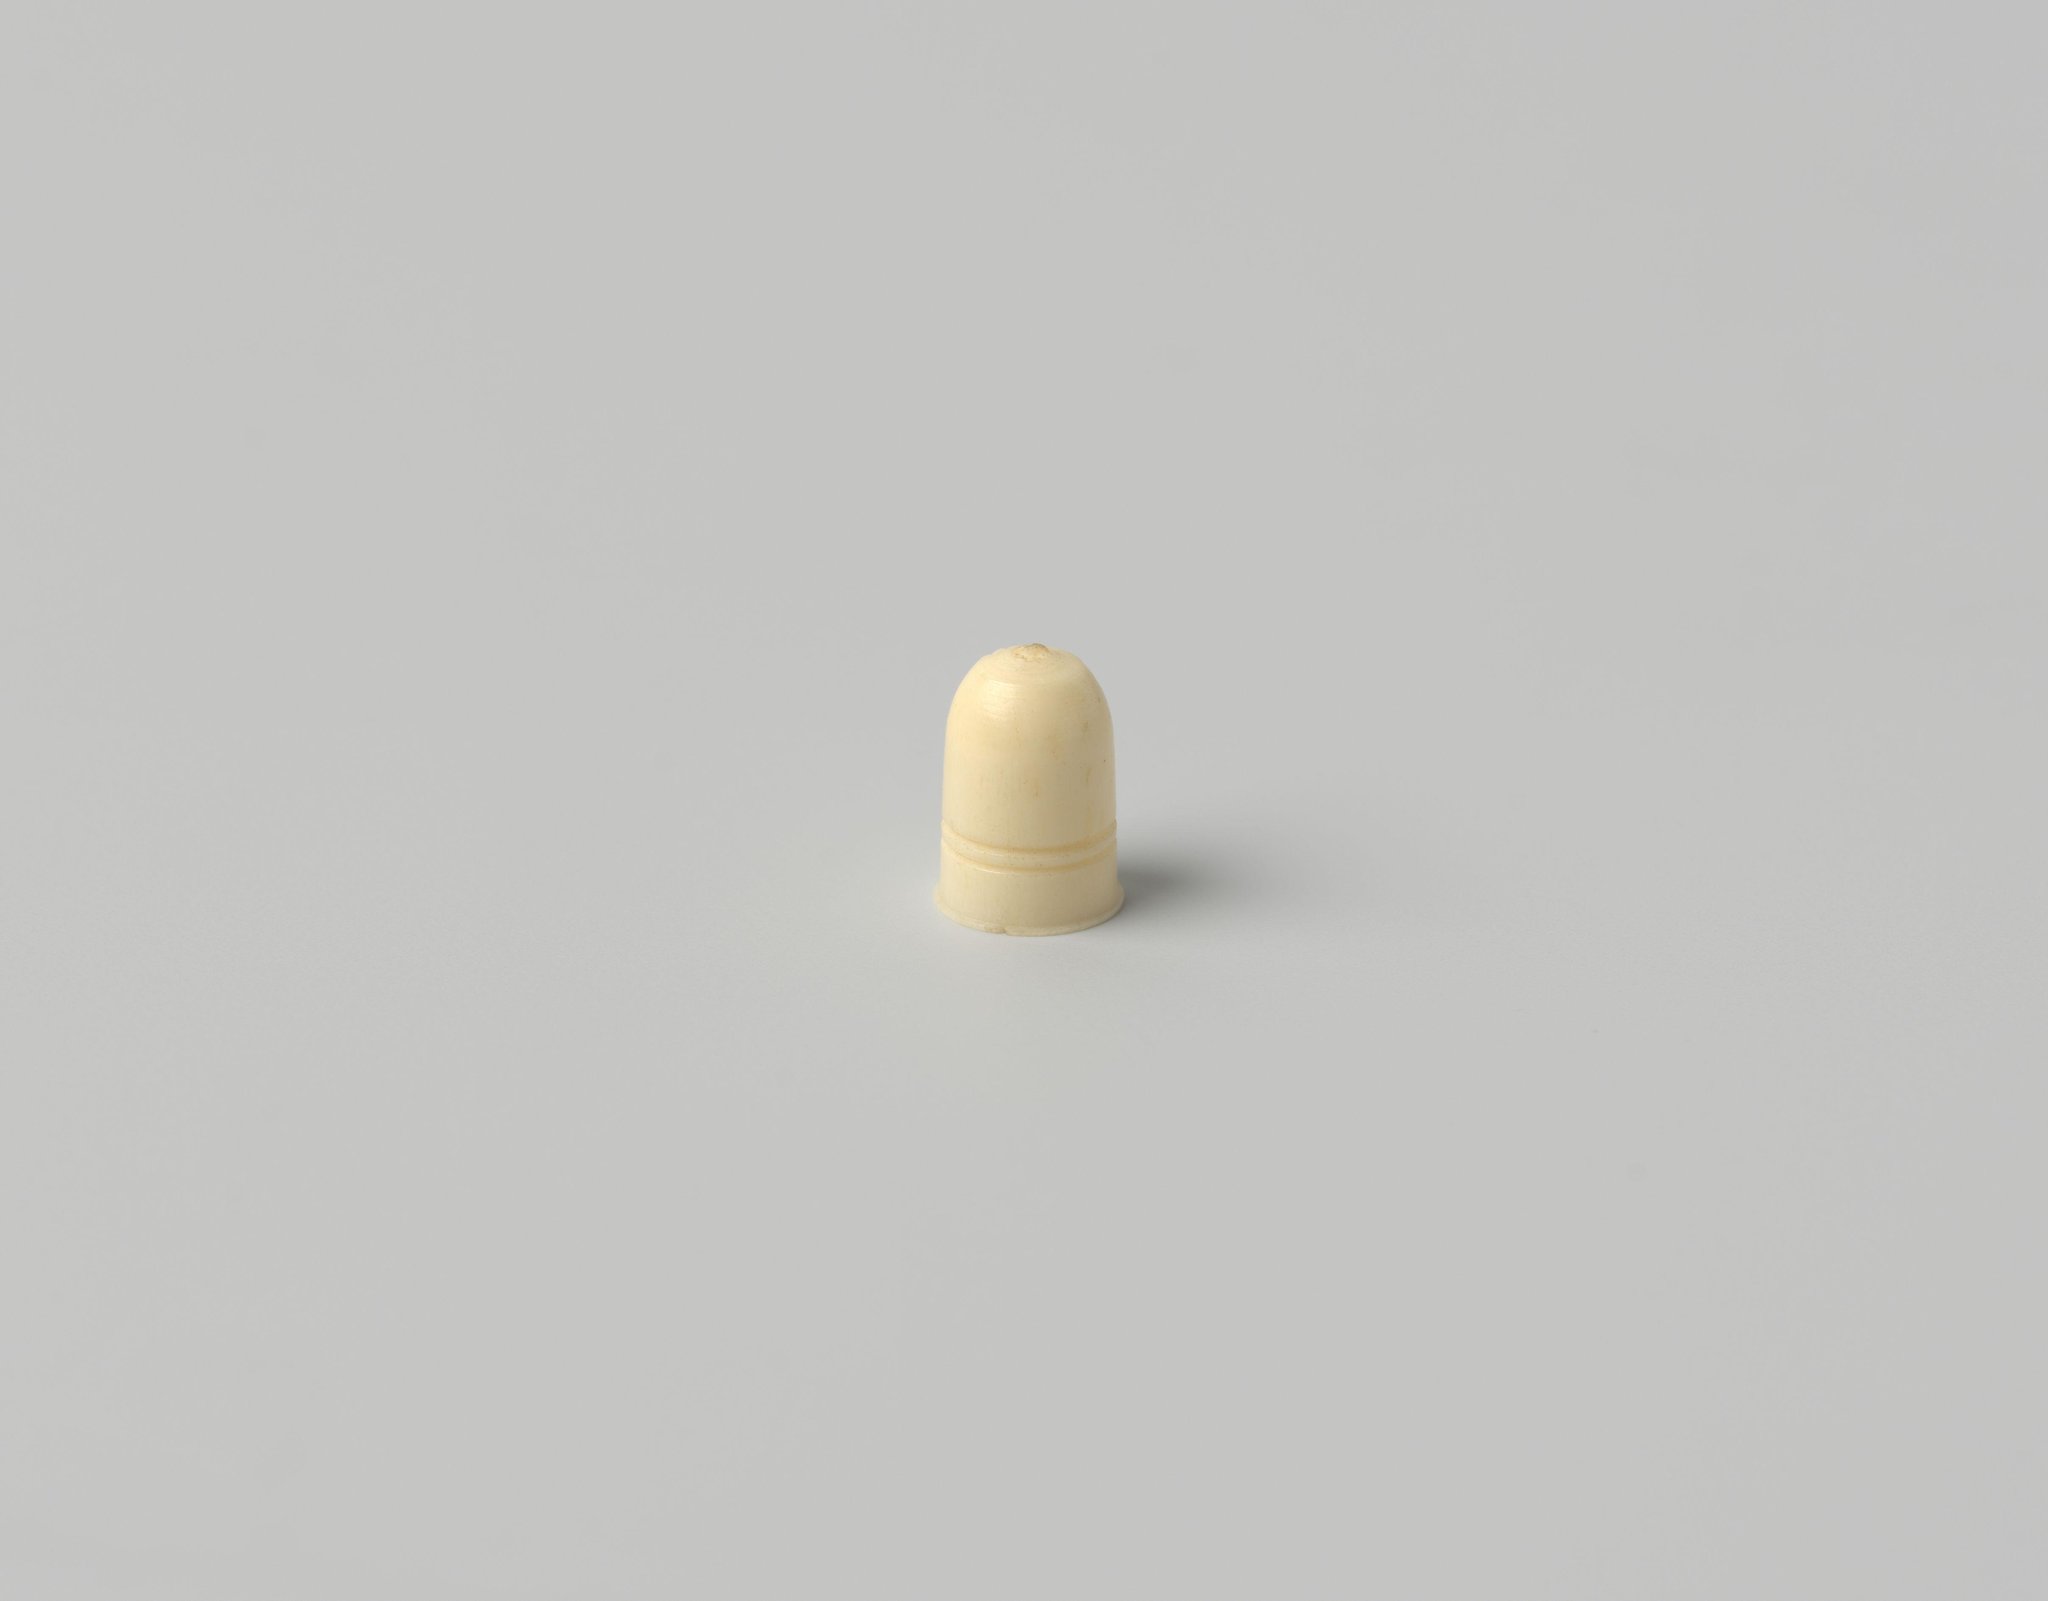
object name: poppengoed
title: Vingerhoed van ivoor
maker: Anonymous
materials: ivory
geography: netherlands